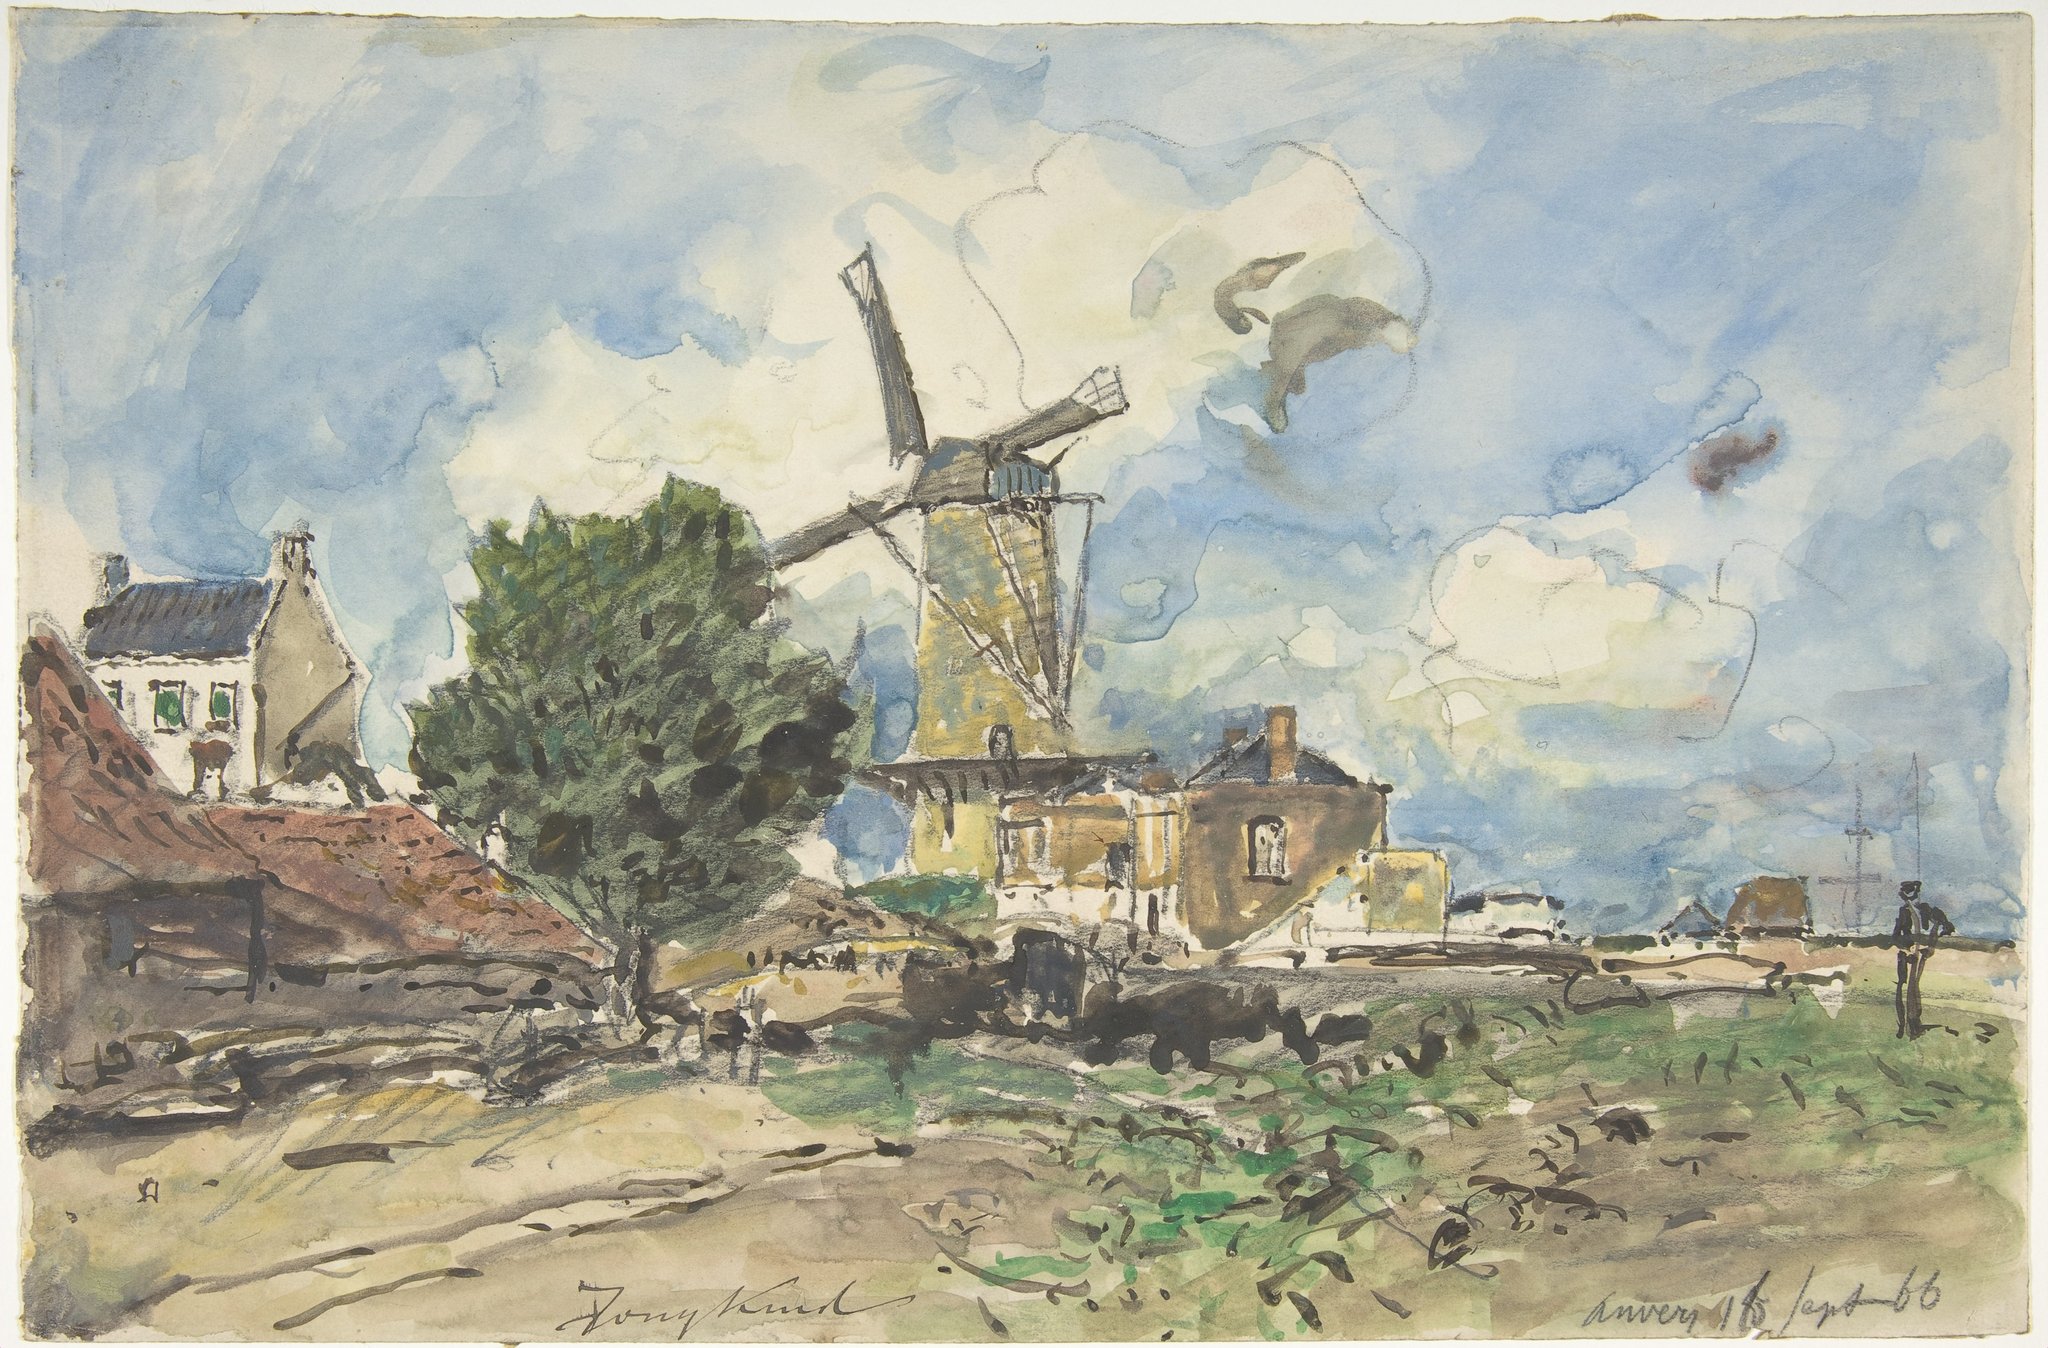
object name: drawing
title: Wind Mill at Antwerp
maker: johan barthold jongkind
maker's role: artist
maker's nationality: dutch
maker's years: 1819-1891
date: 1866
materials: chalk, watercolor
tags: houses,windmills